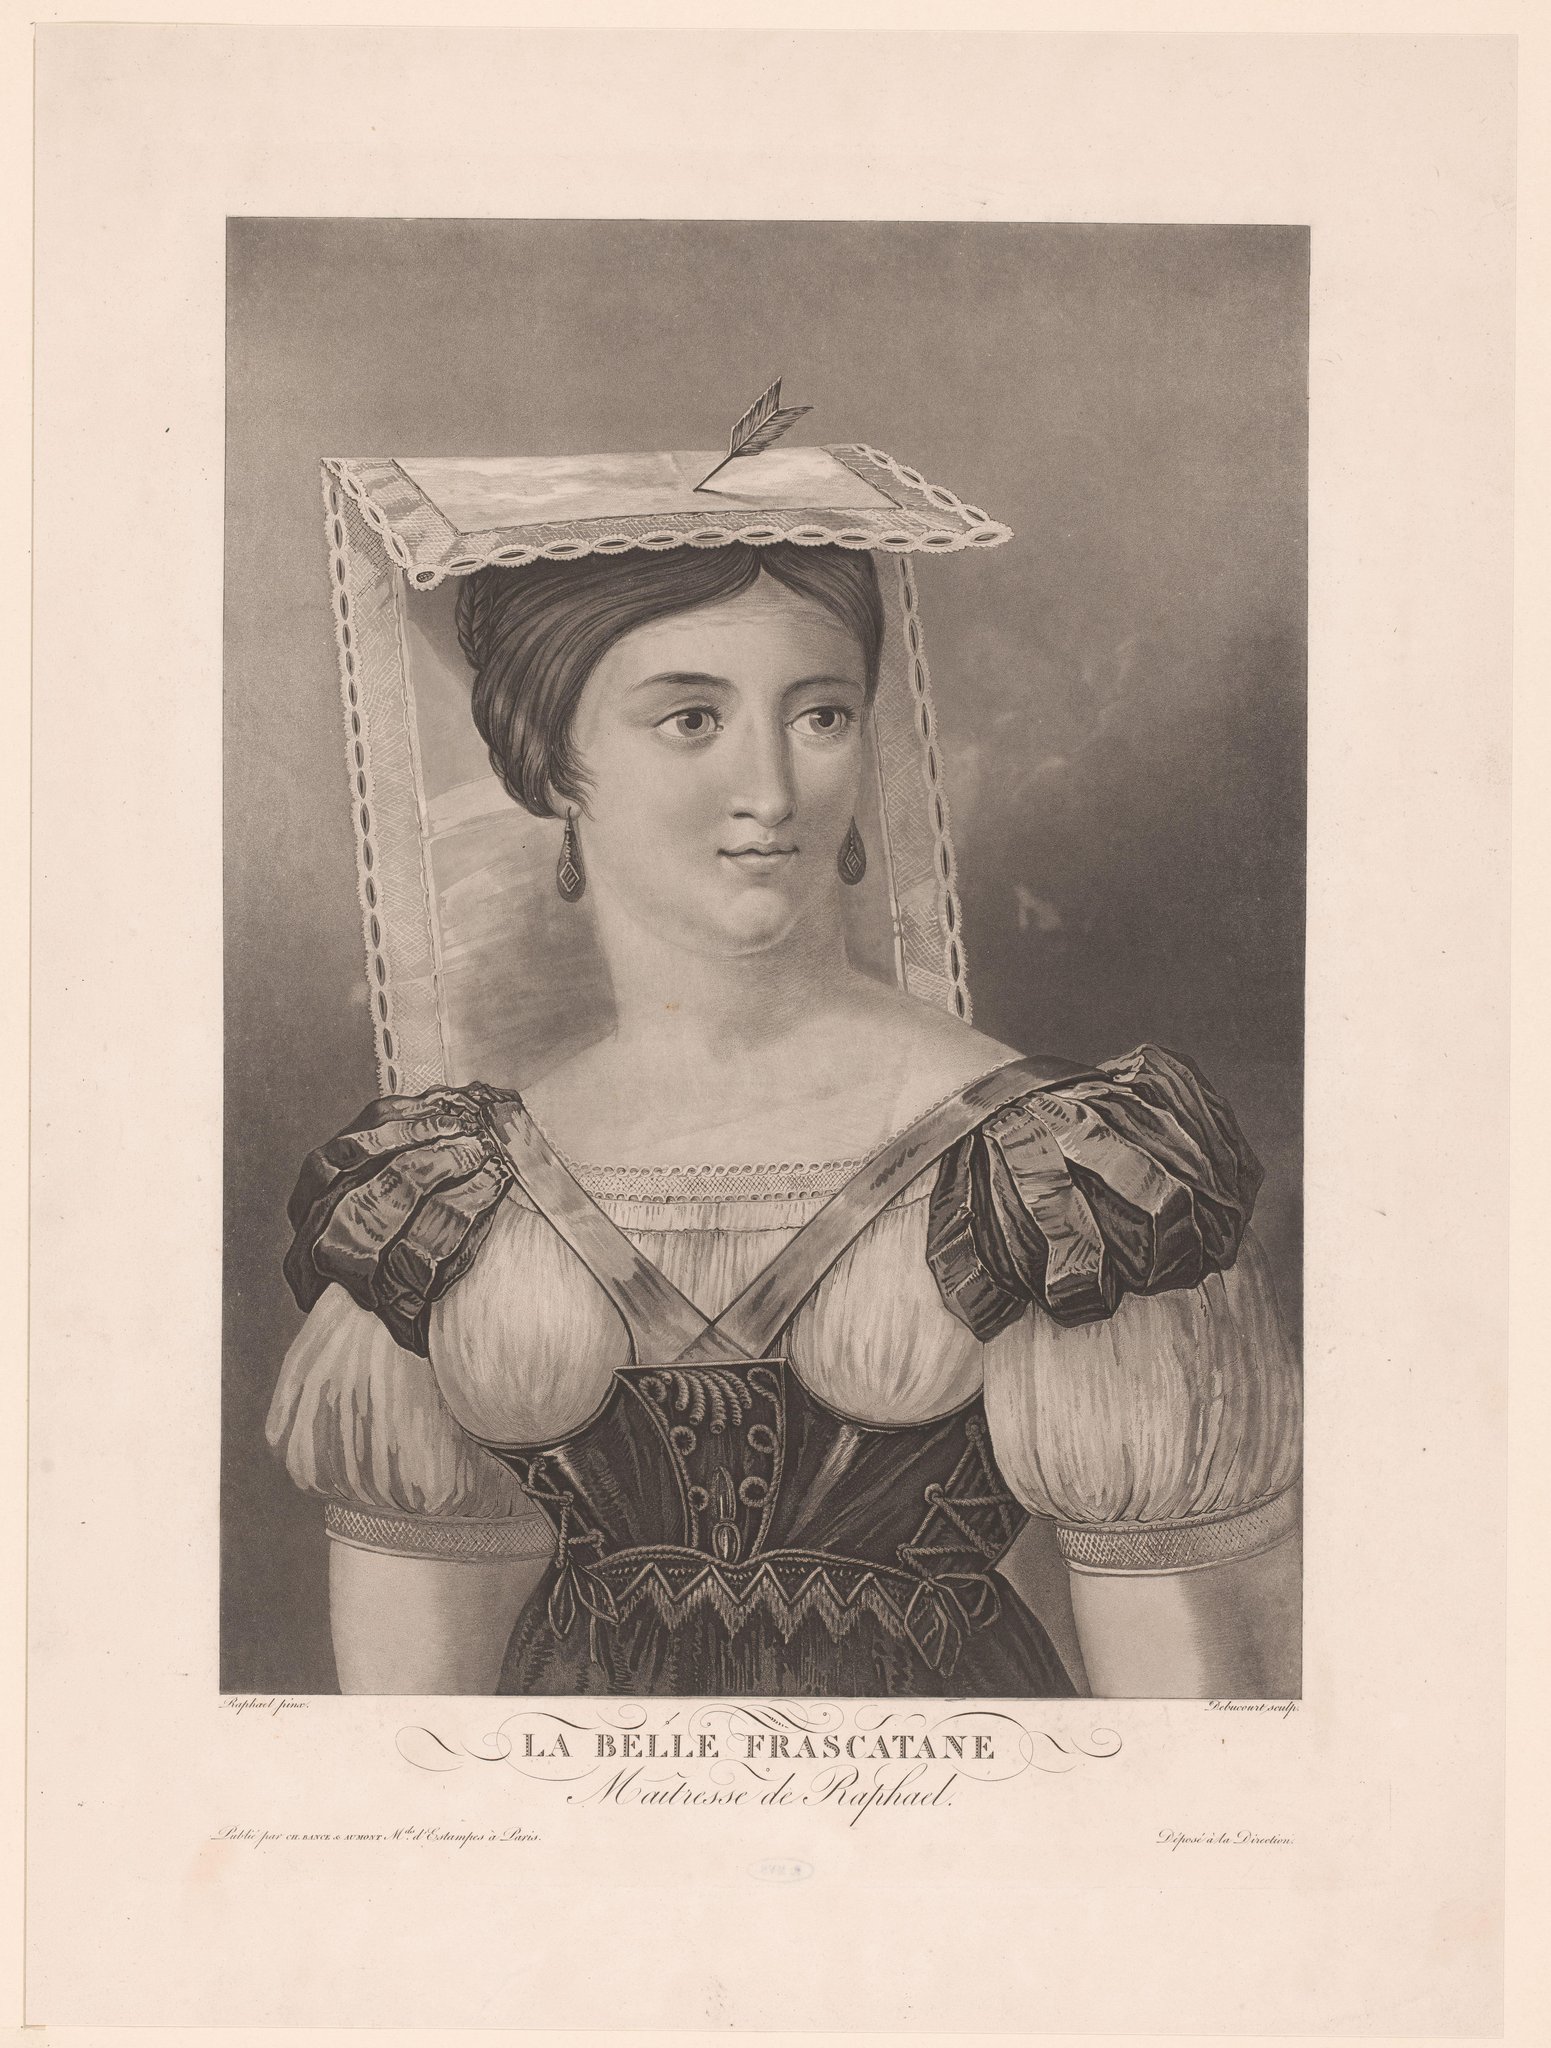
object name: print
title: Portretten van vrouwen van bekende schilders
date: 1821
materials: paper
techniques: aquatint, etching, roulette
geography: paris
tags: adult woman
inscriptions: collector's mark: Lugt 2228